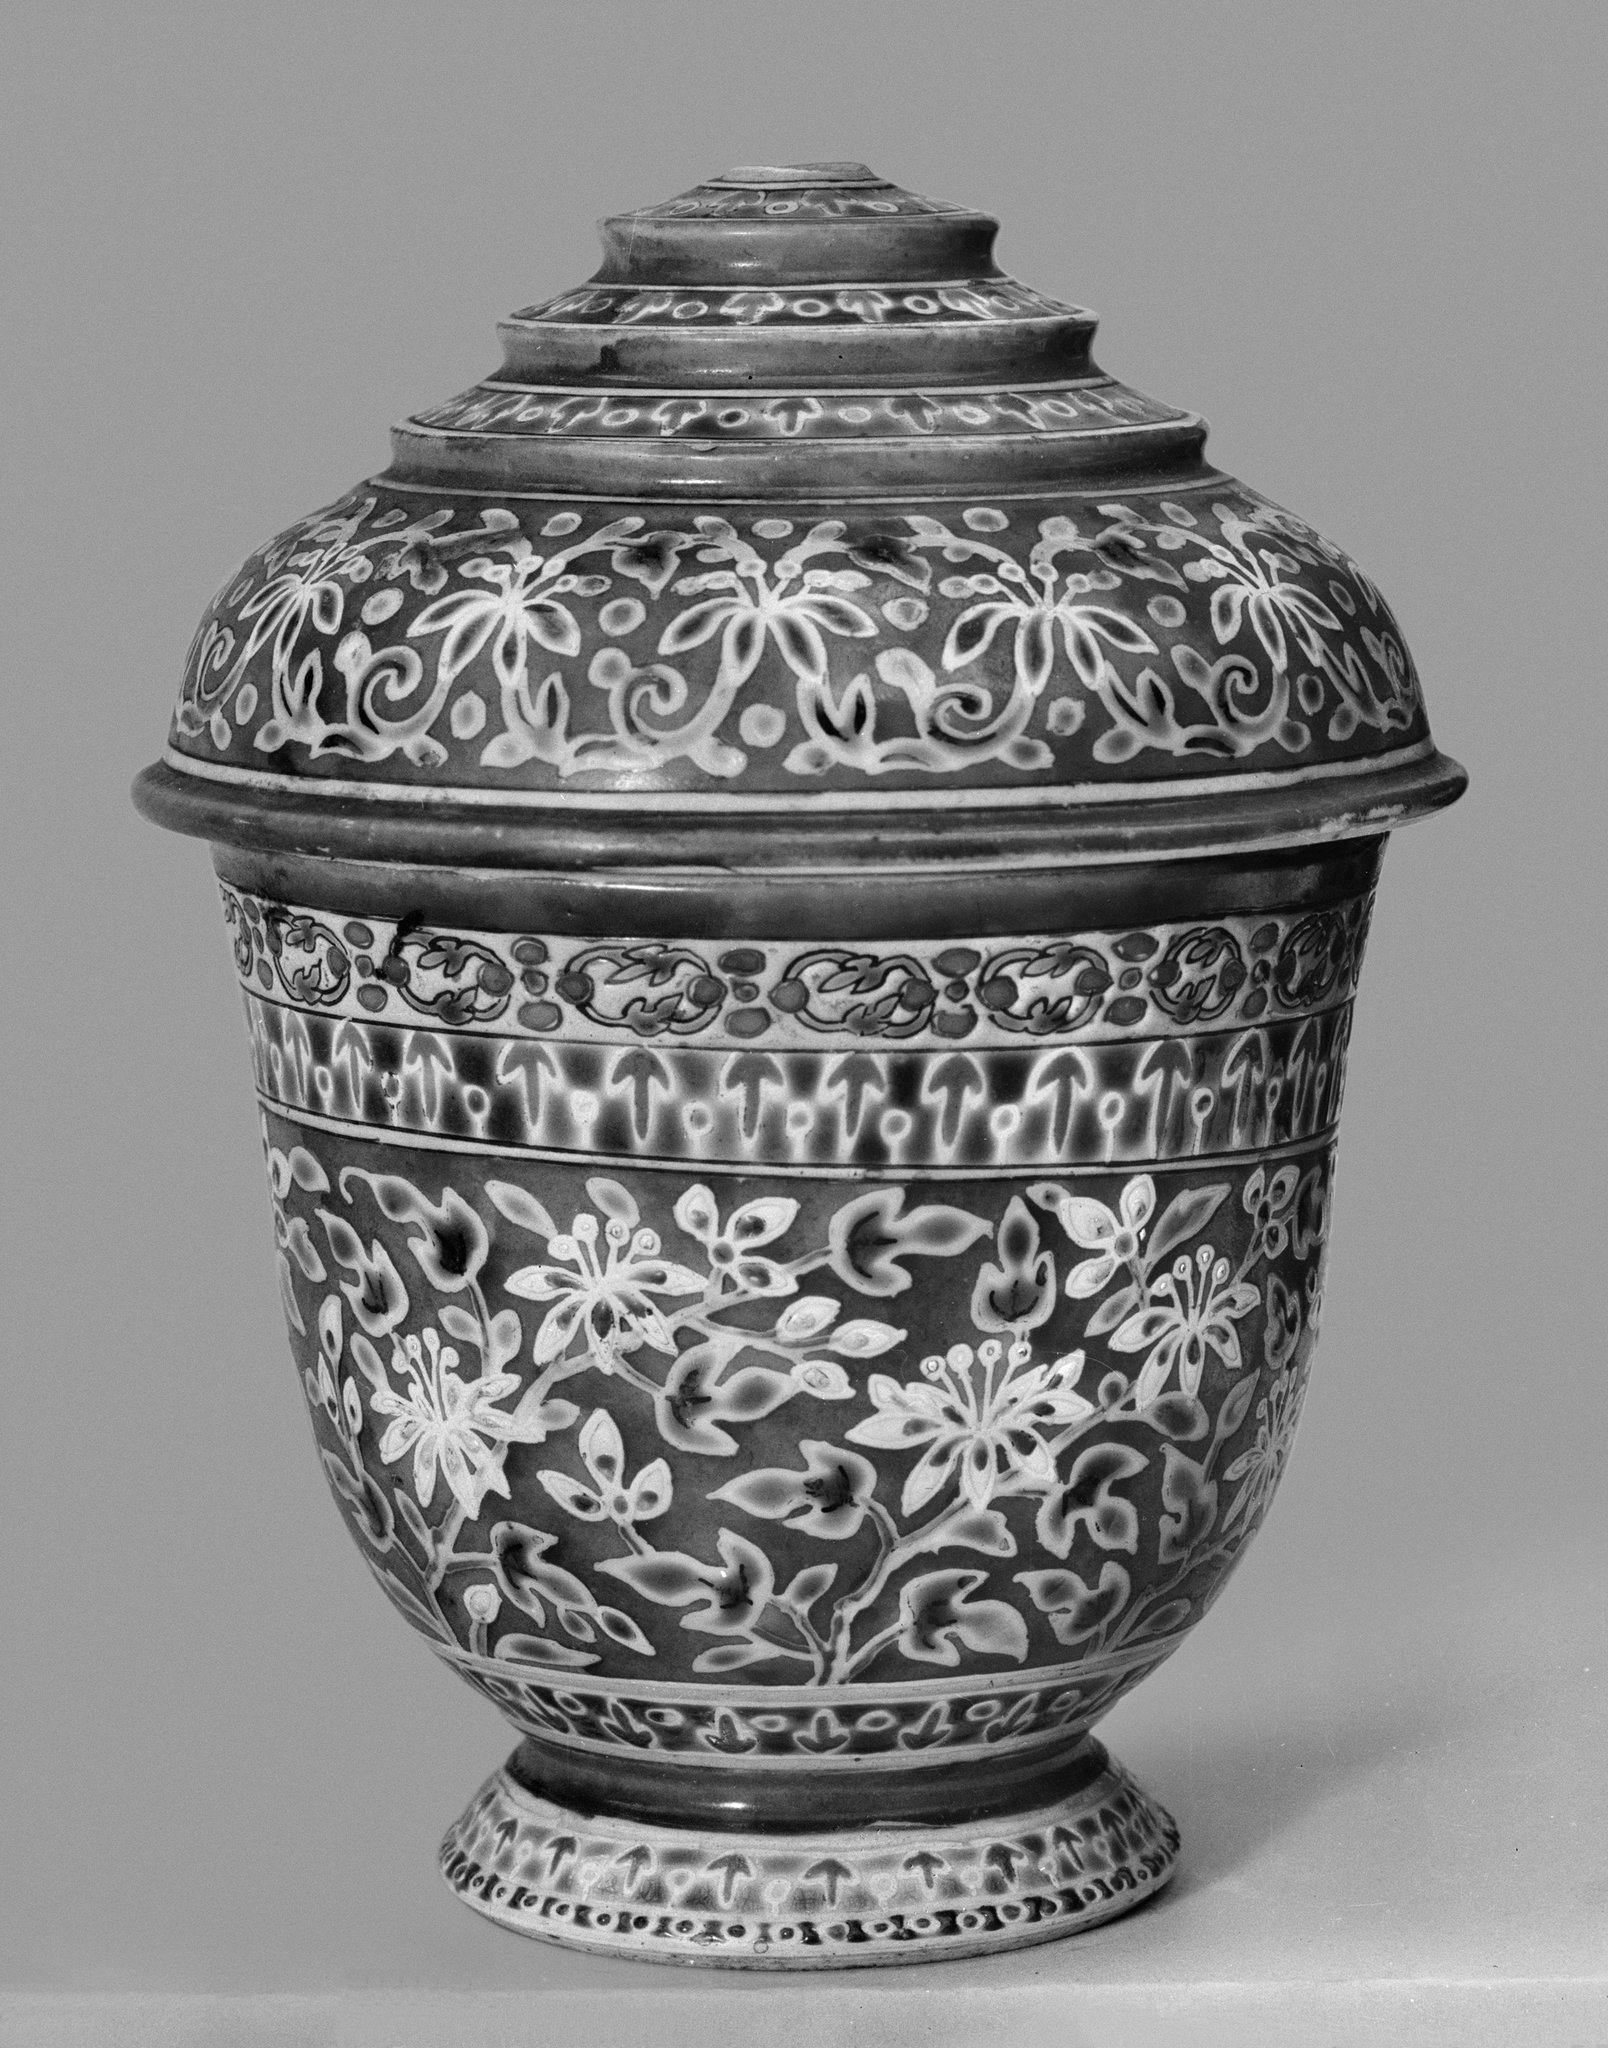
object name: covered bowl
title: Covered bowl with floral pattern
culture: chinese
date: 1801-1900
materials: enamel, porcelain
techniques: overglaze, painting, polychrome